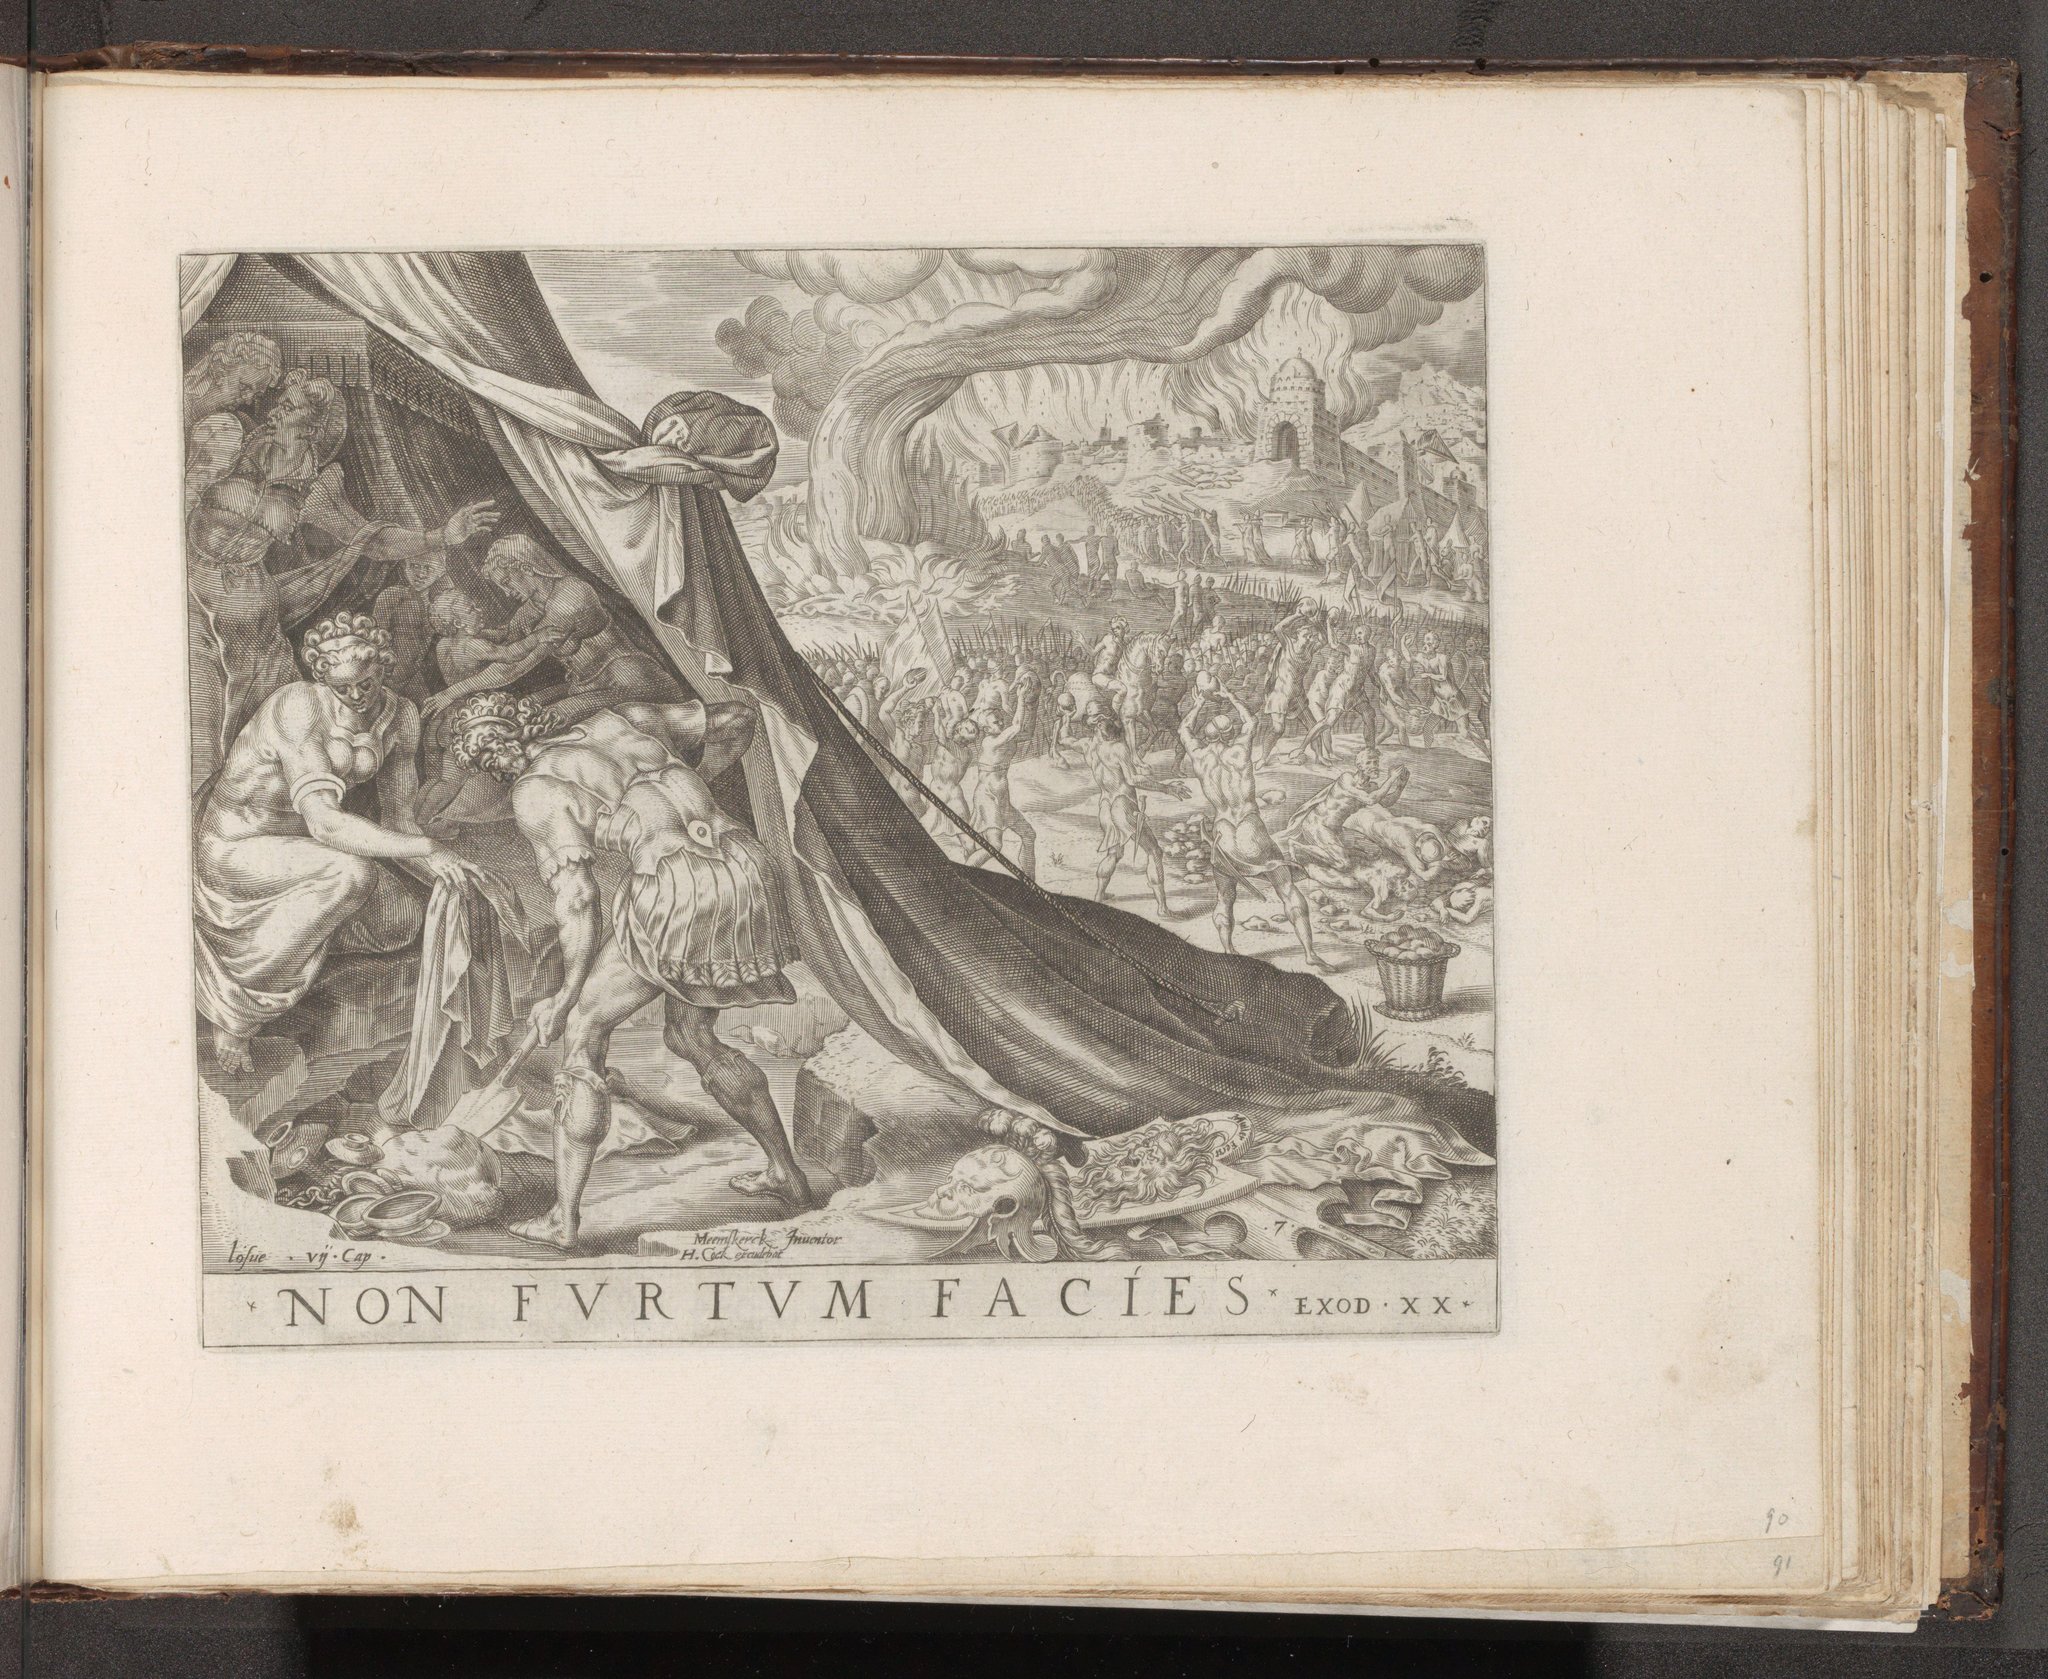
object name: album leaf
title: Thesaurus sacrarum historiaru[m] veteris testame[n]ti, elega[n]tissimis imaginibus expressu[m] excelle[n]tissimoru[m] in hac arte viroru[m] opera: nu[n]c primu[m] in luce[m] editus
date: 1564-1568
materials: paper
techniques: engraving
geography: antwerp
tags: achan's sin (aftermath of the fall of jericho) (joshua 7), 'you shall not steal' ~ separate representation of the eigth of the ten commandments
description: Achan begraaft de oorlogsbuit, die bestemd was voor God, in zijn tent. Op de achtergrond worden Achan en zijn familie om deze zonde gestenigd. Geheel in de achtergrond de verwoesting van Jericho. Prent maakt deel uit van een serie over de tien geboden en geeft een overtreding van het zevende gebod weer: Gij zult niet stelen. Onderaan in de marge een verwijzing naar de Bijbeltekst in het Latijn. Prent maakt deel uit van een album.